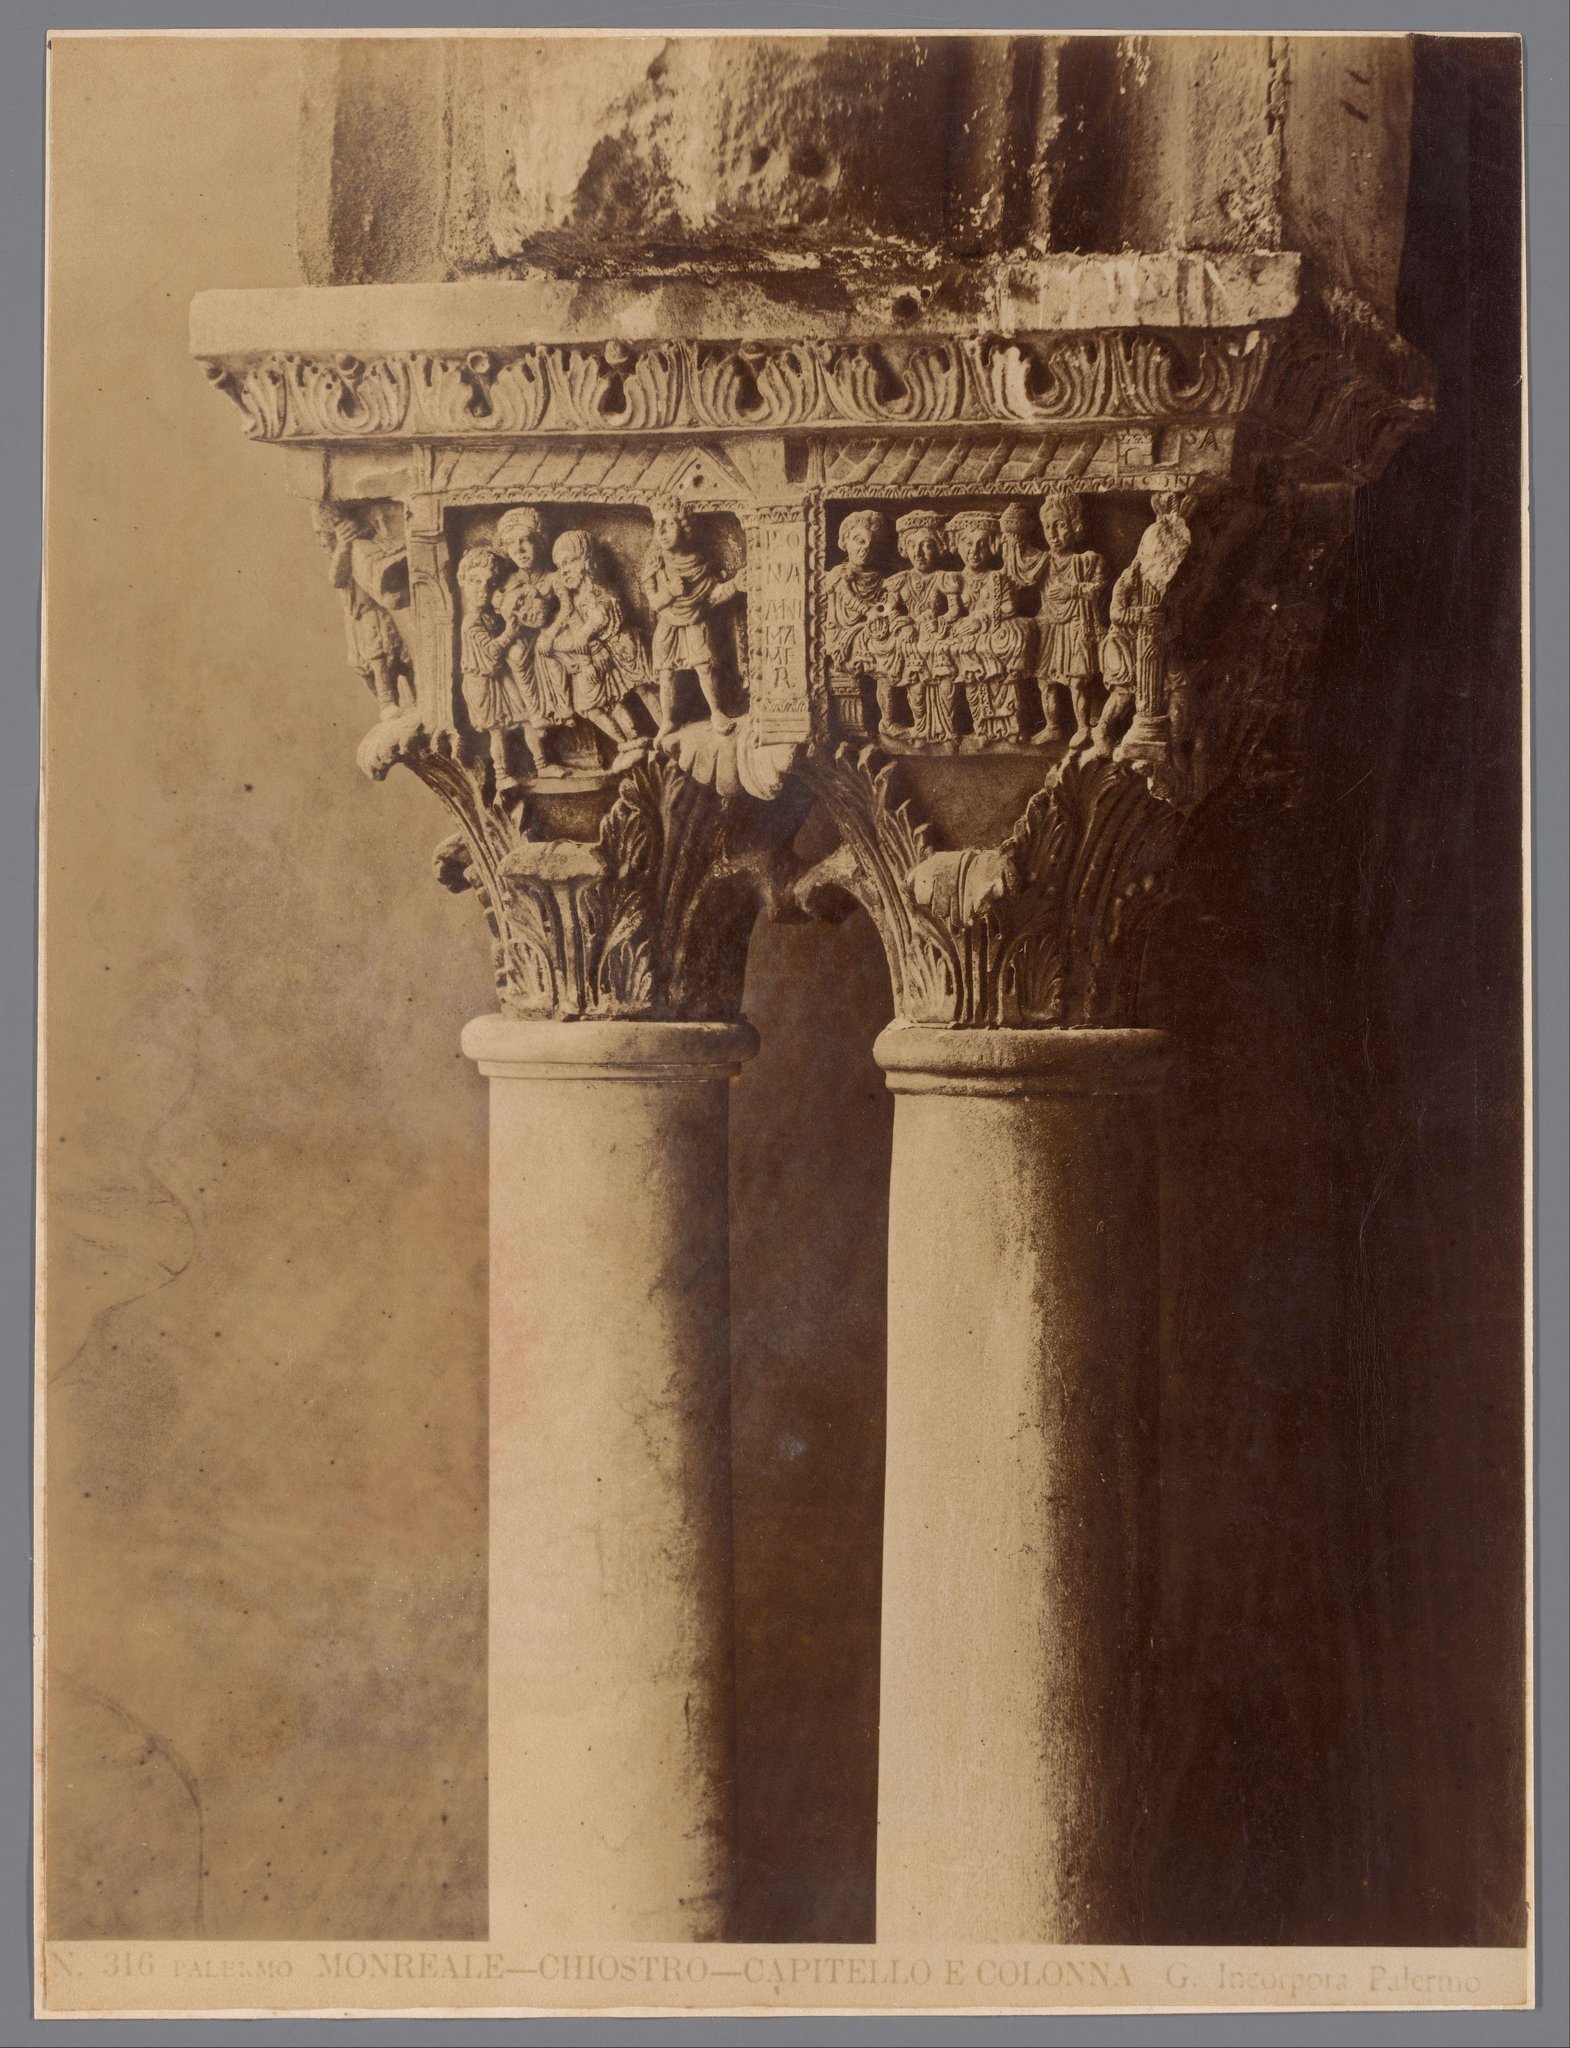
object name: photograph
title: Monreale, Chiostro, capitello e colonna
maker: giuseppe incorpora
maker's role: fotograaf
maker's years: 1834-1914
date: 1856-1914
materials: cardboard, paper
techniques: albumen print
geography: monreale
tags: abbey, monastery, convent ~ roman catholic church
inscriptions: number: ‘N. 316’